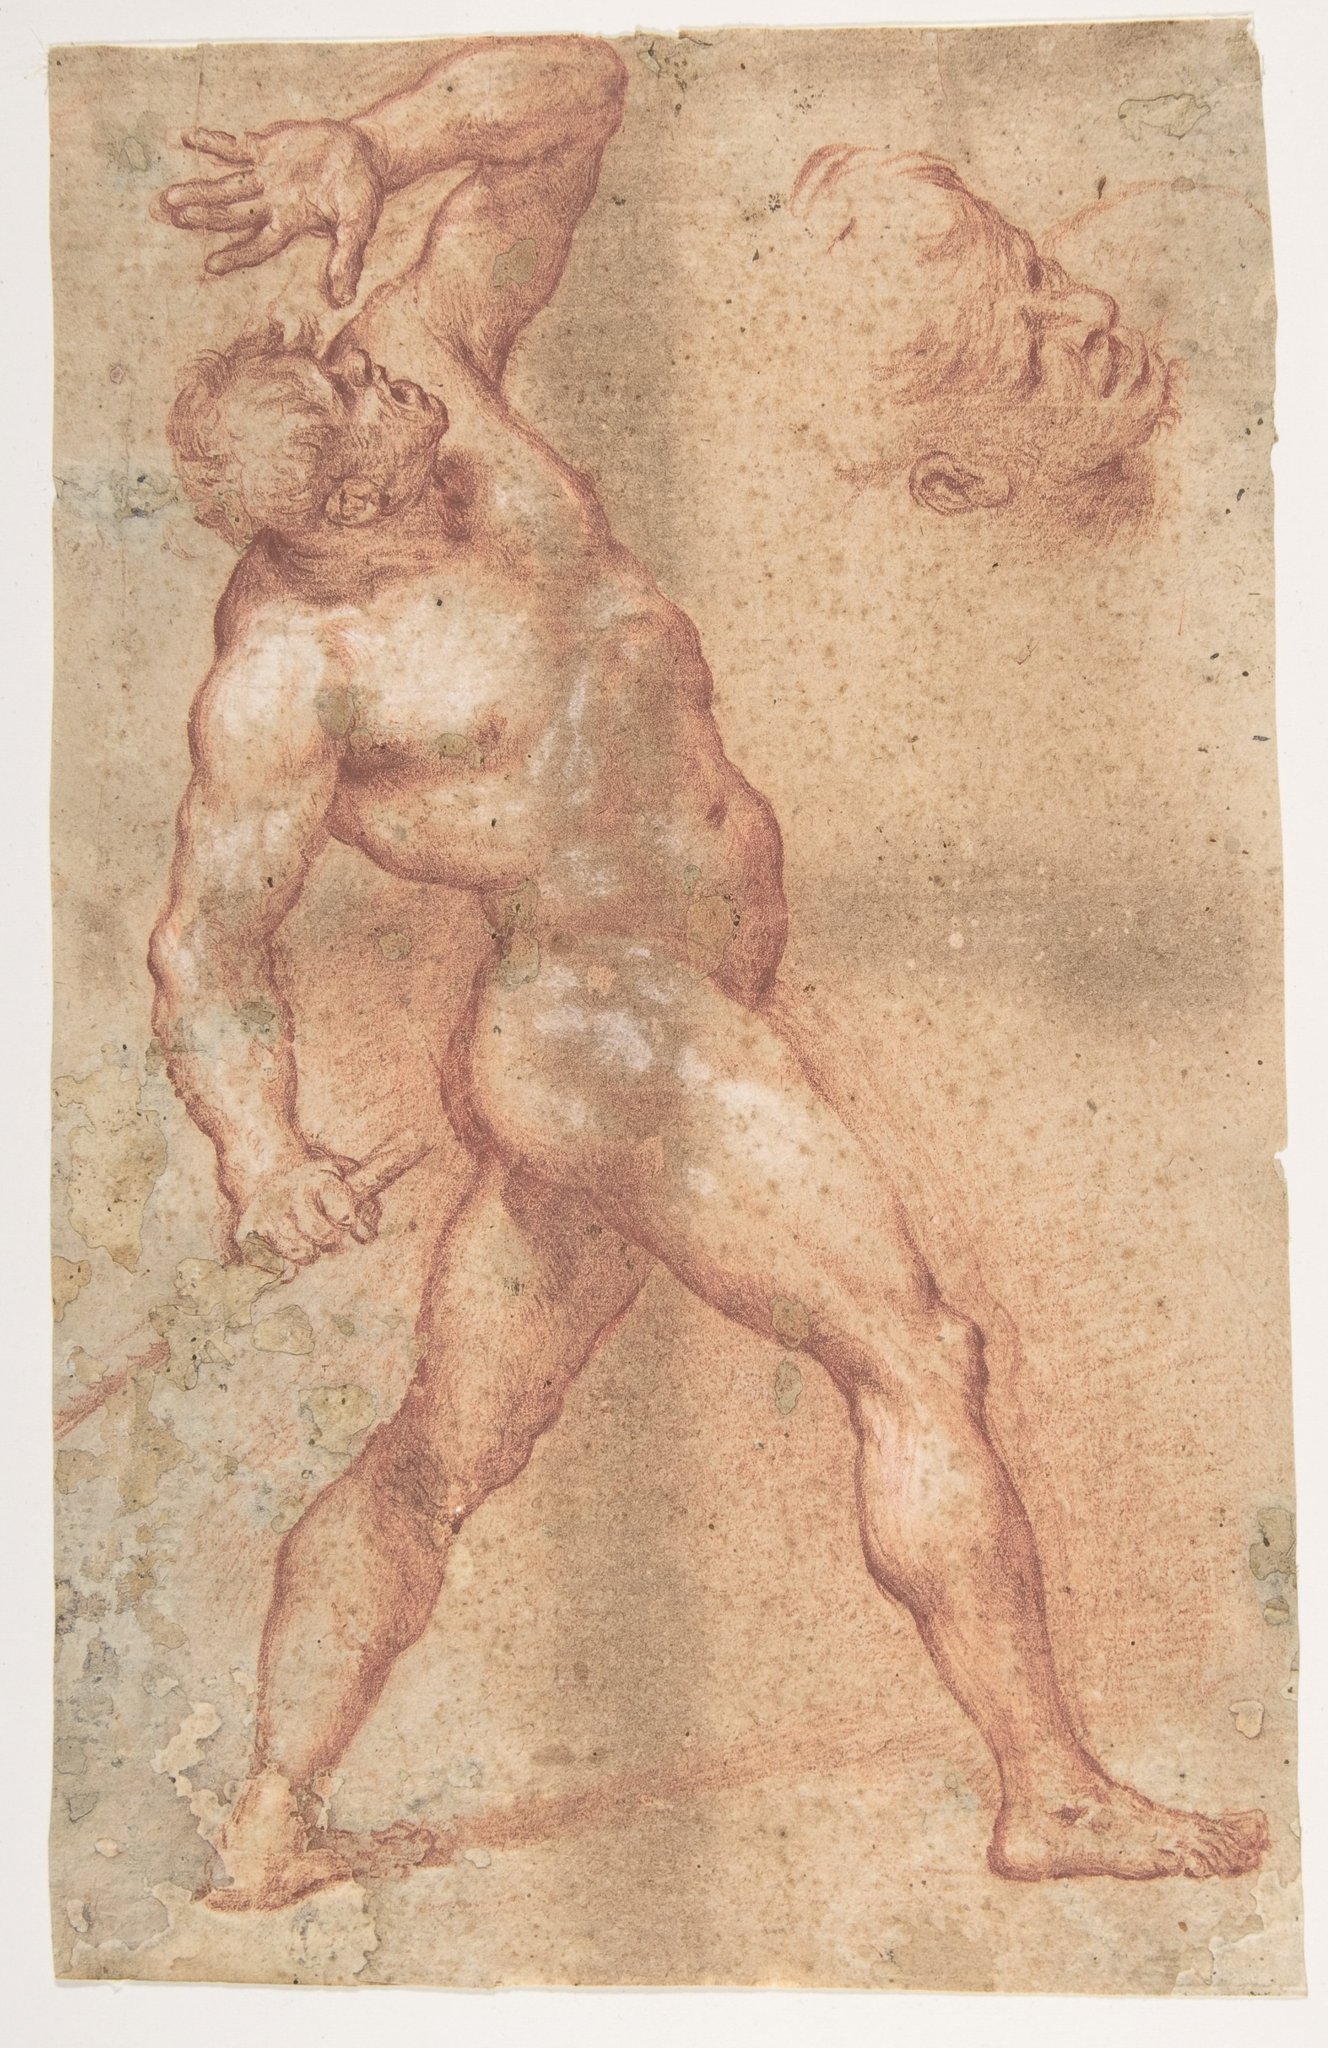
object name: drawing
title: Male Nude with Left Arm Upraised, and a Further Study of His Head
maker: aniello falcone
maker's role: artist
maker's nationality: italian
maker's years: 1607-1656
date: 1607-1656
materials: chalk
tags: male nudes